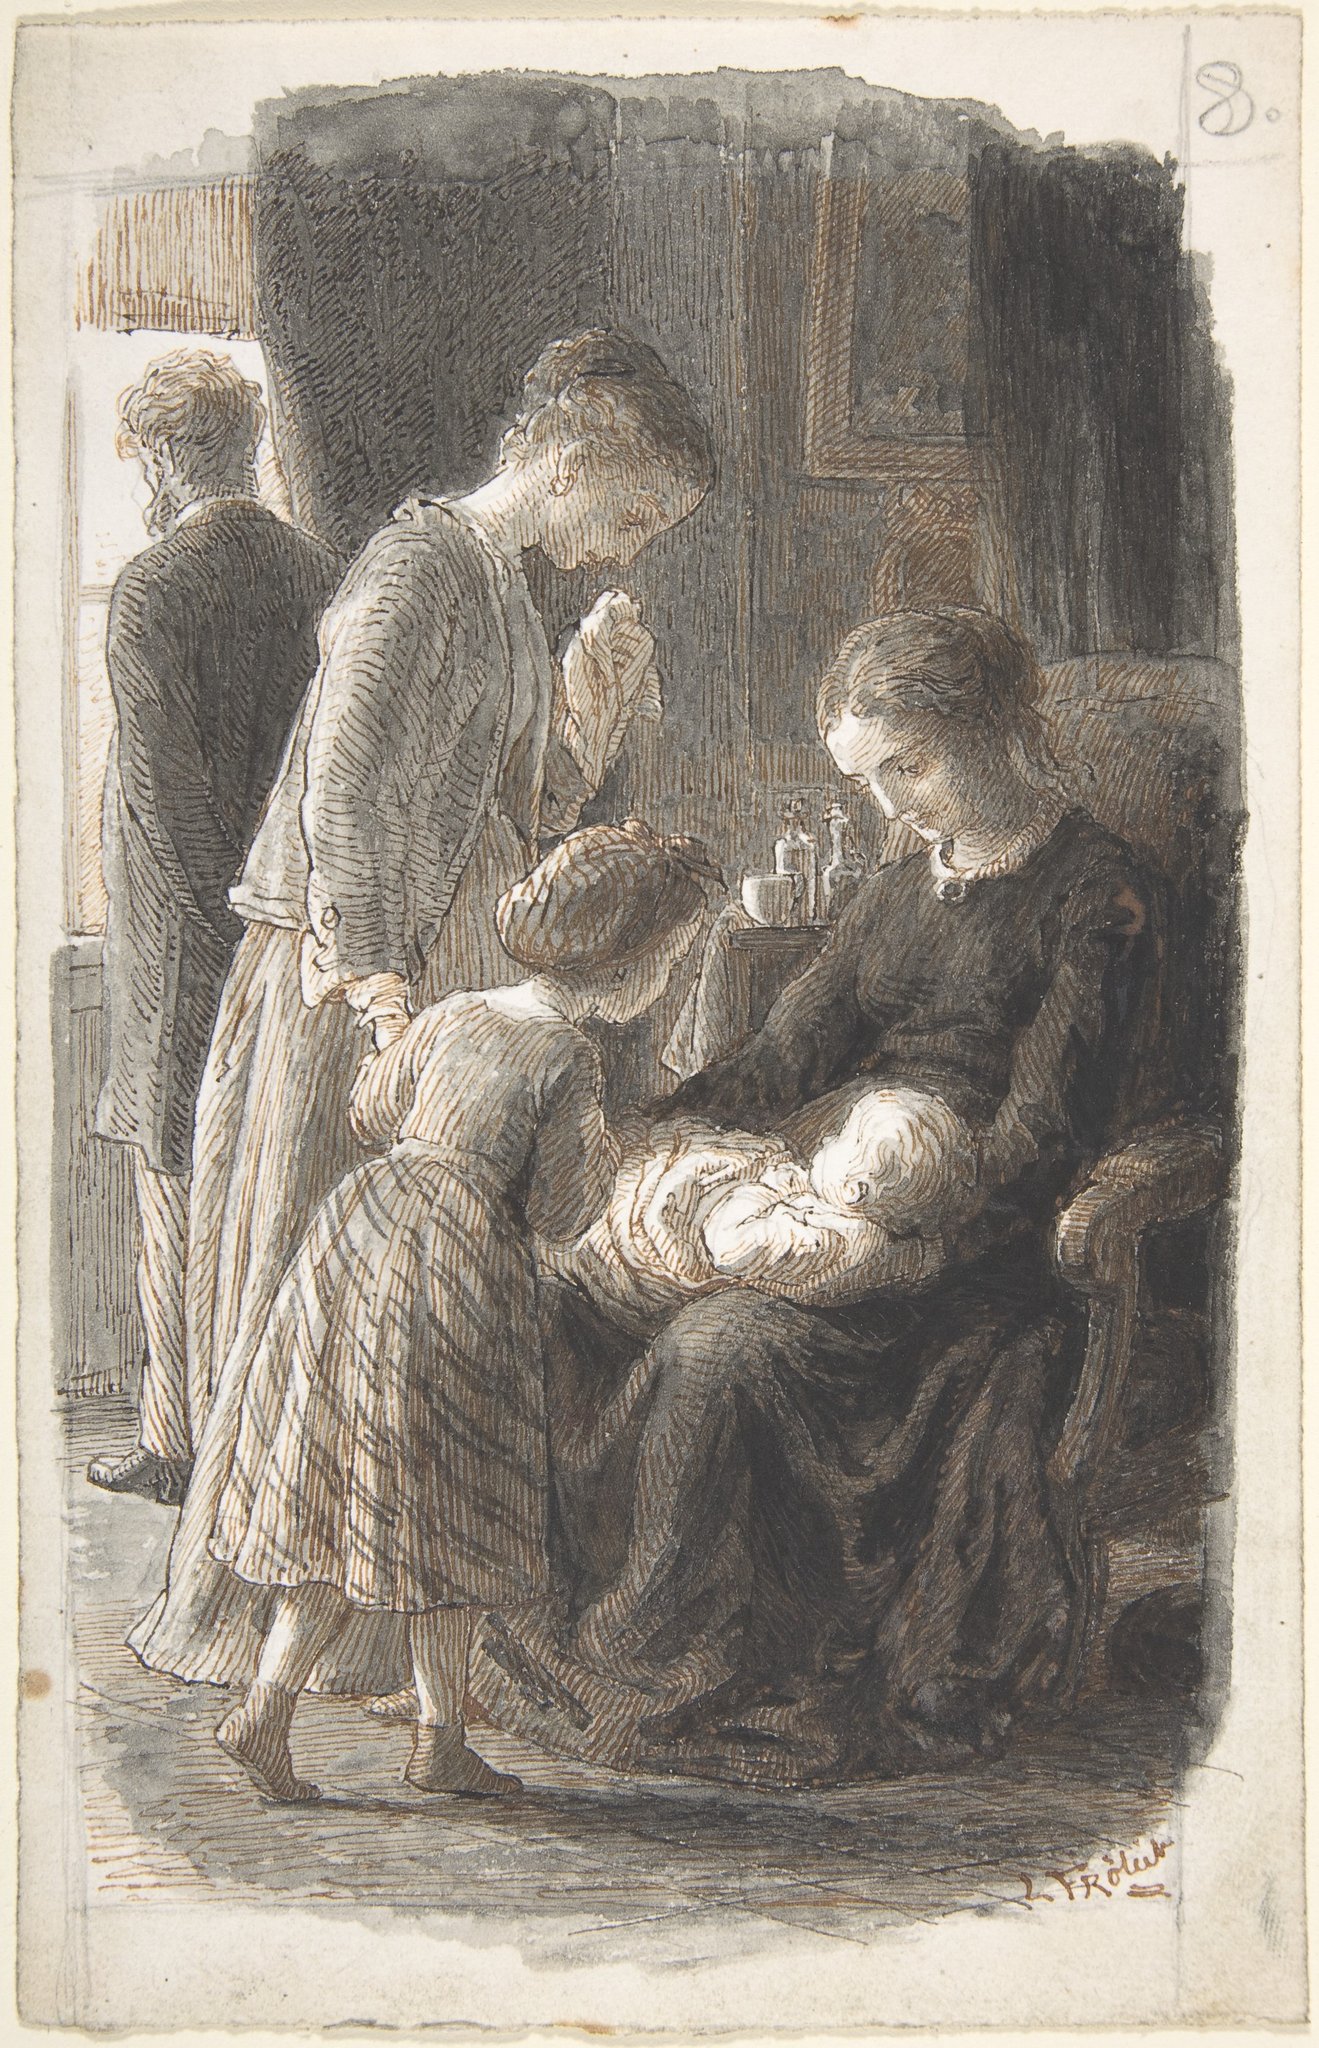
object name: drawing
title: The Young Family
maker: lorenz frølich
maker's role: artist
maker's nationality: danish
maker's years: 1820-1908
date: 1835-1903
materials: graphite, ink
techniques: brush, pen, wash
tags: girls,infants,men,women,family